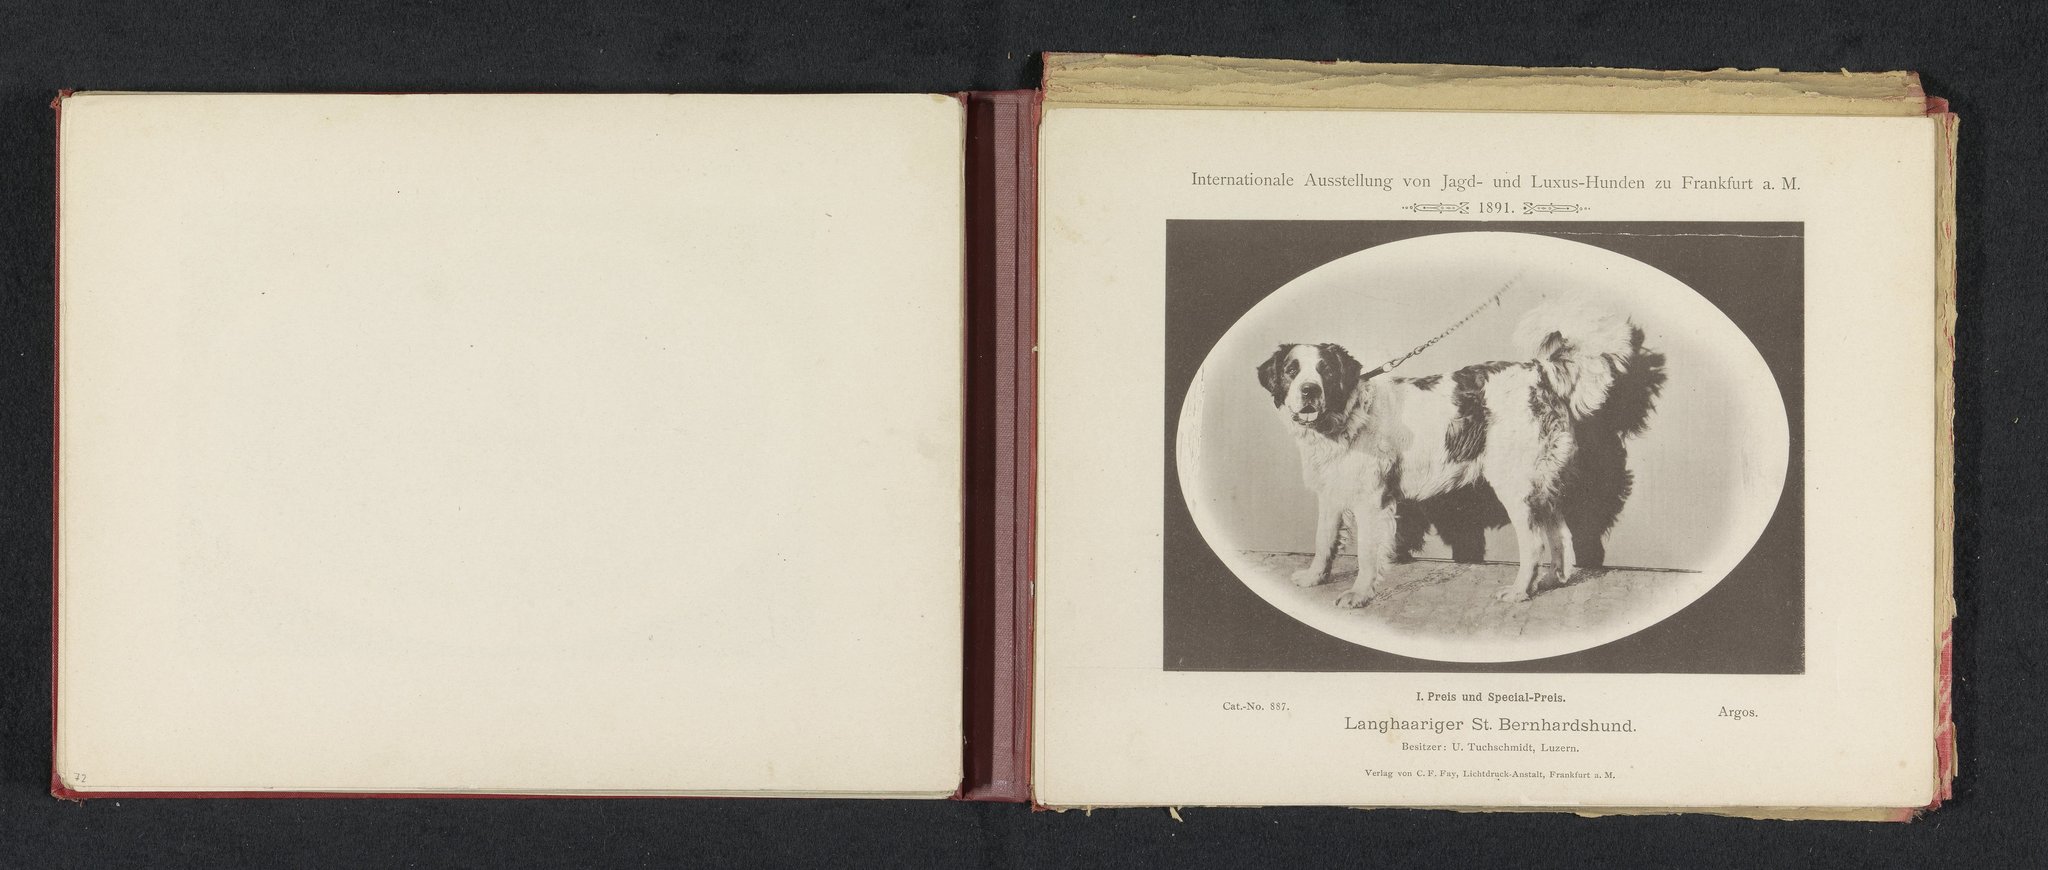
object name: page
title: Sint-bernard Argos die twee prijzen heeft gewonnen op de Internationale Ausstellung von Jagd und Luxus Hunden in 1891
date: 1891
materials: paper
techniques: photograph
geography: frankfurt am main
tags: dog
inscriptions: number: ‘Cat.-No. 887.’, inscription: ‘I. Preis und Special-Preis. Argos. Besitzer : U. Tuchschmidt, Luzern.’